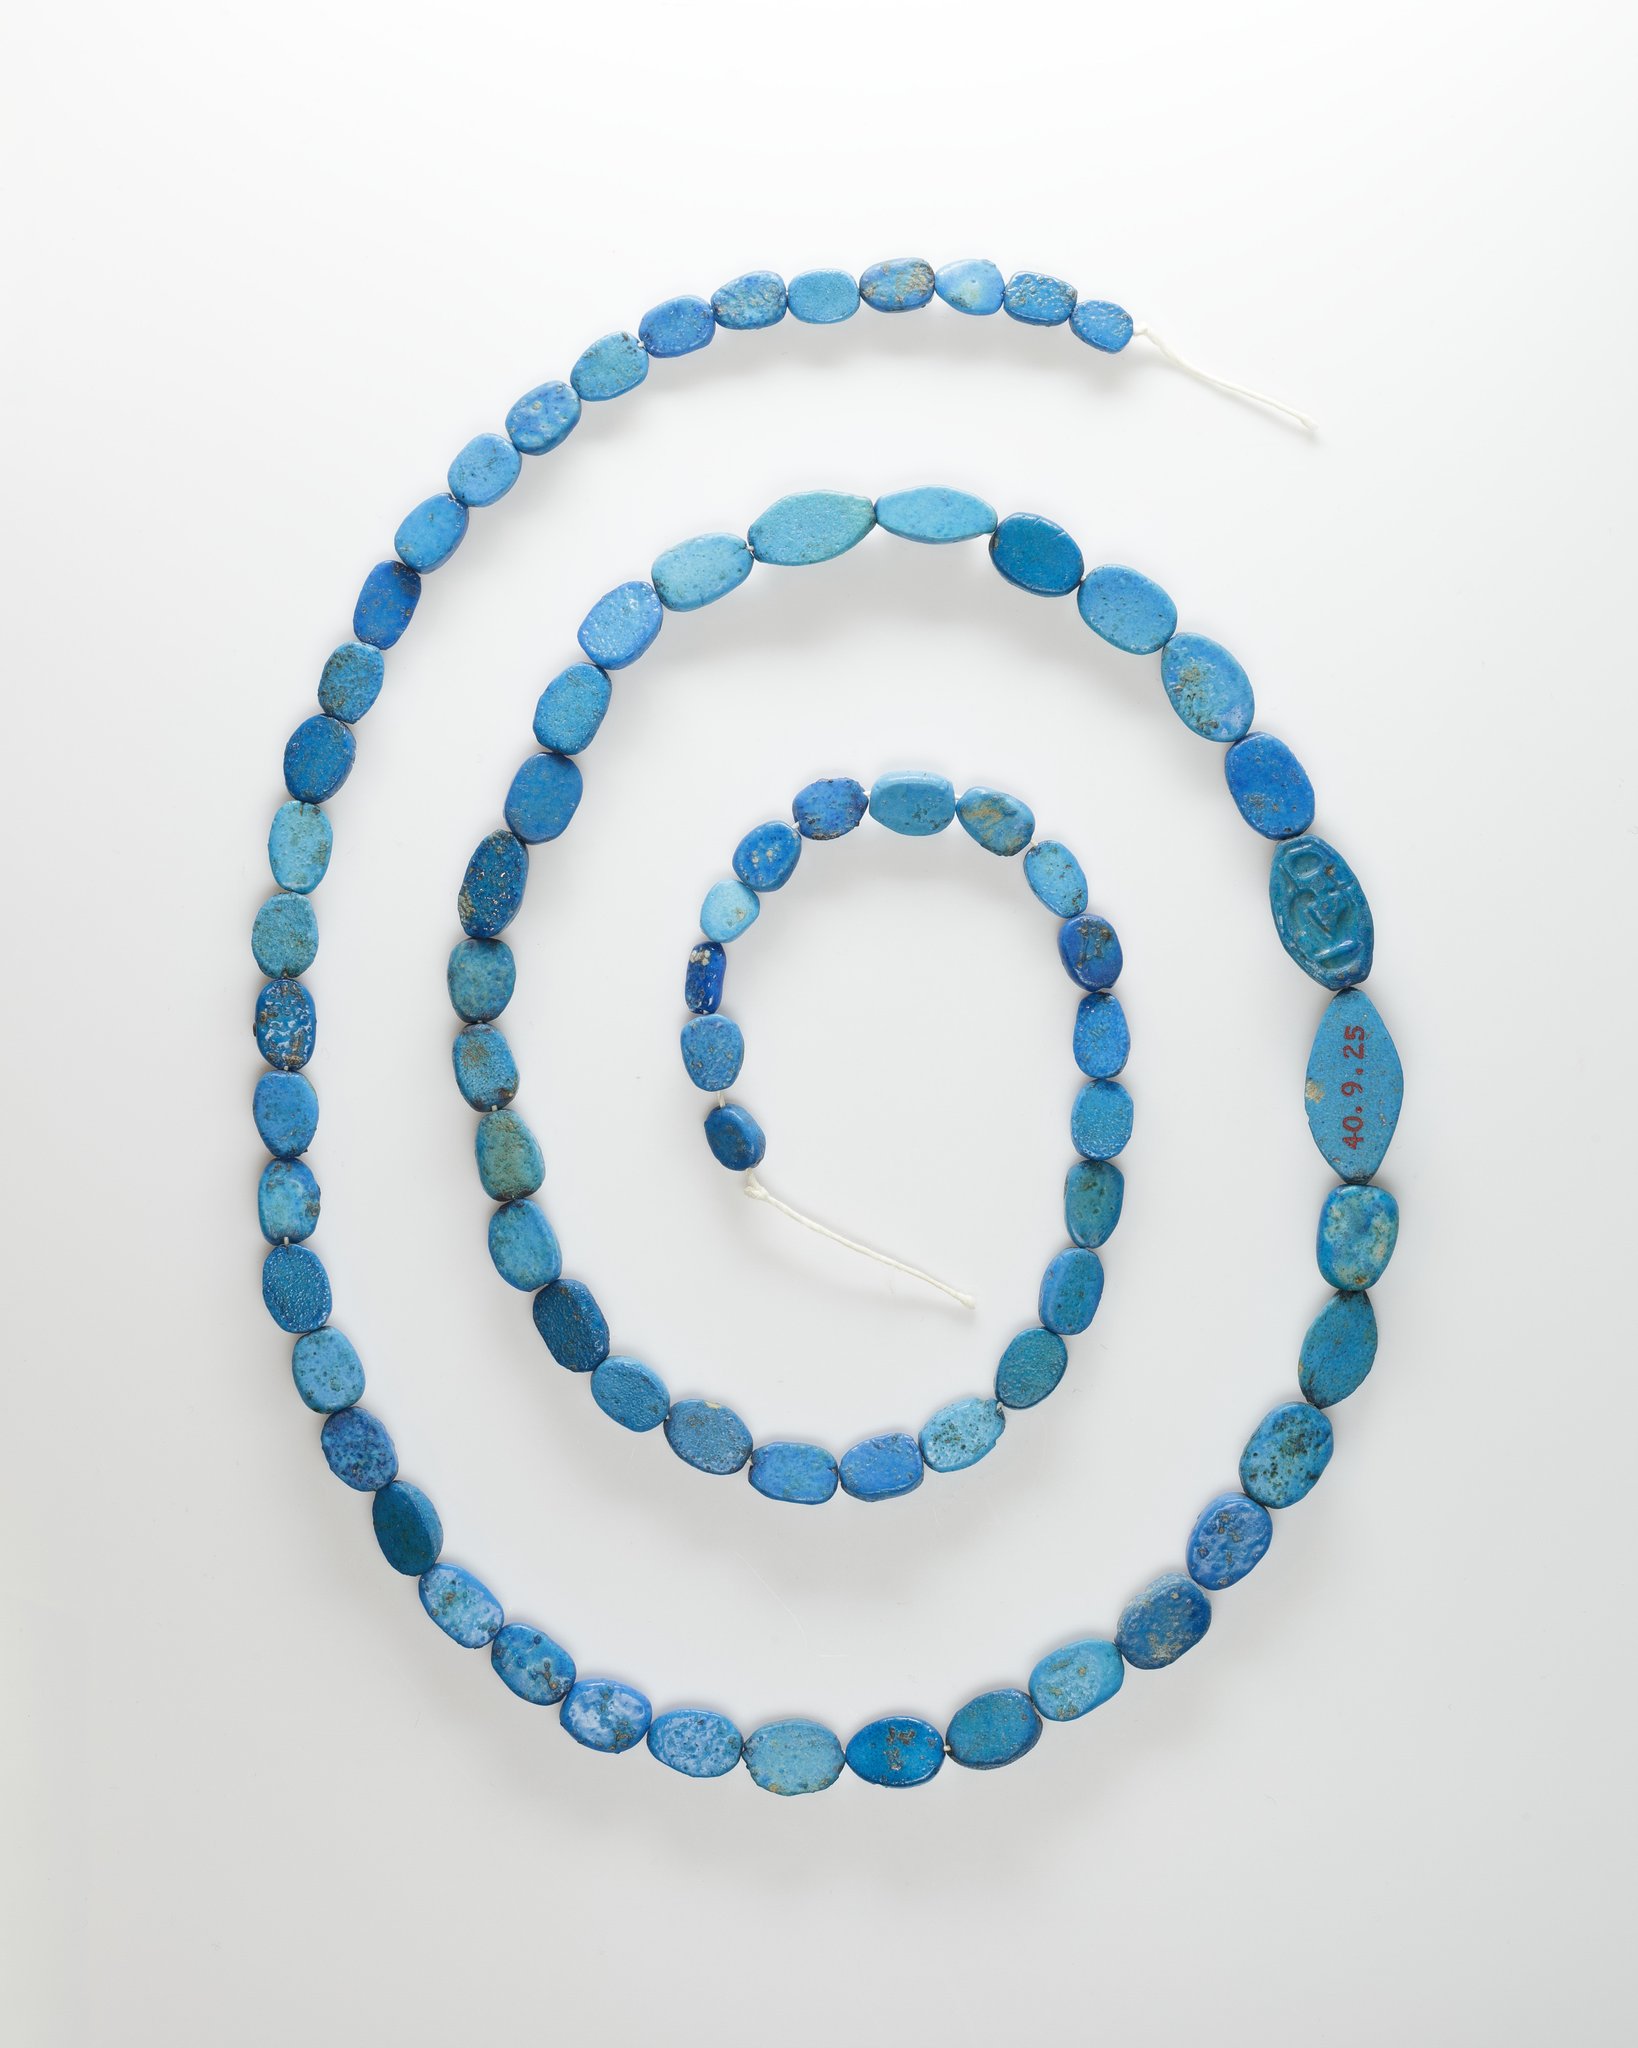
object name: bead, string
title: String of beads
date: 1550-1295 BCE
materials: faience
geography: egypt